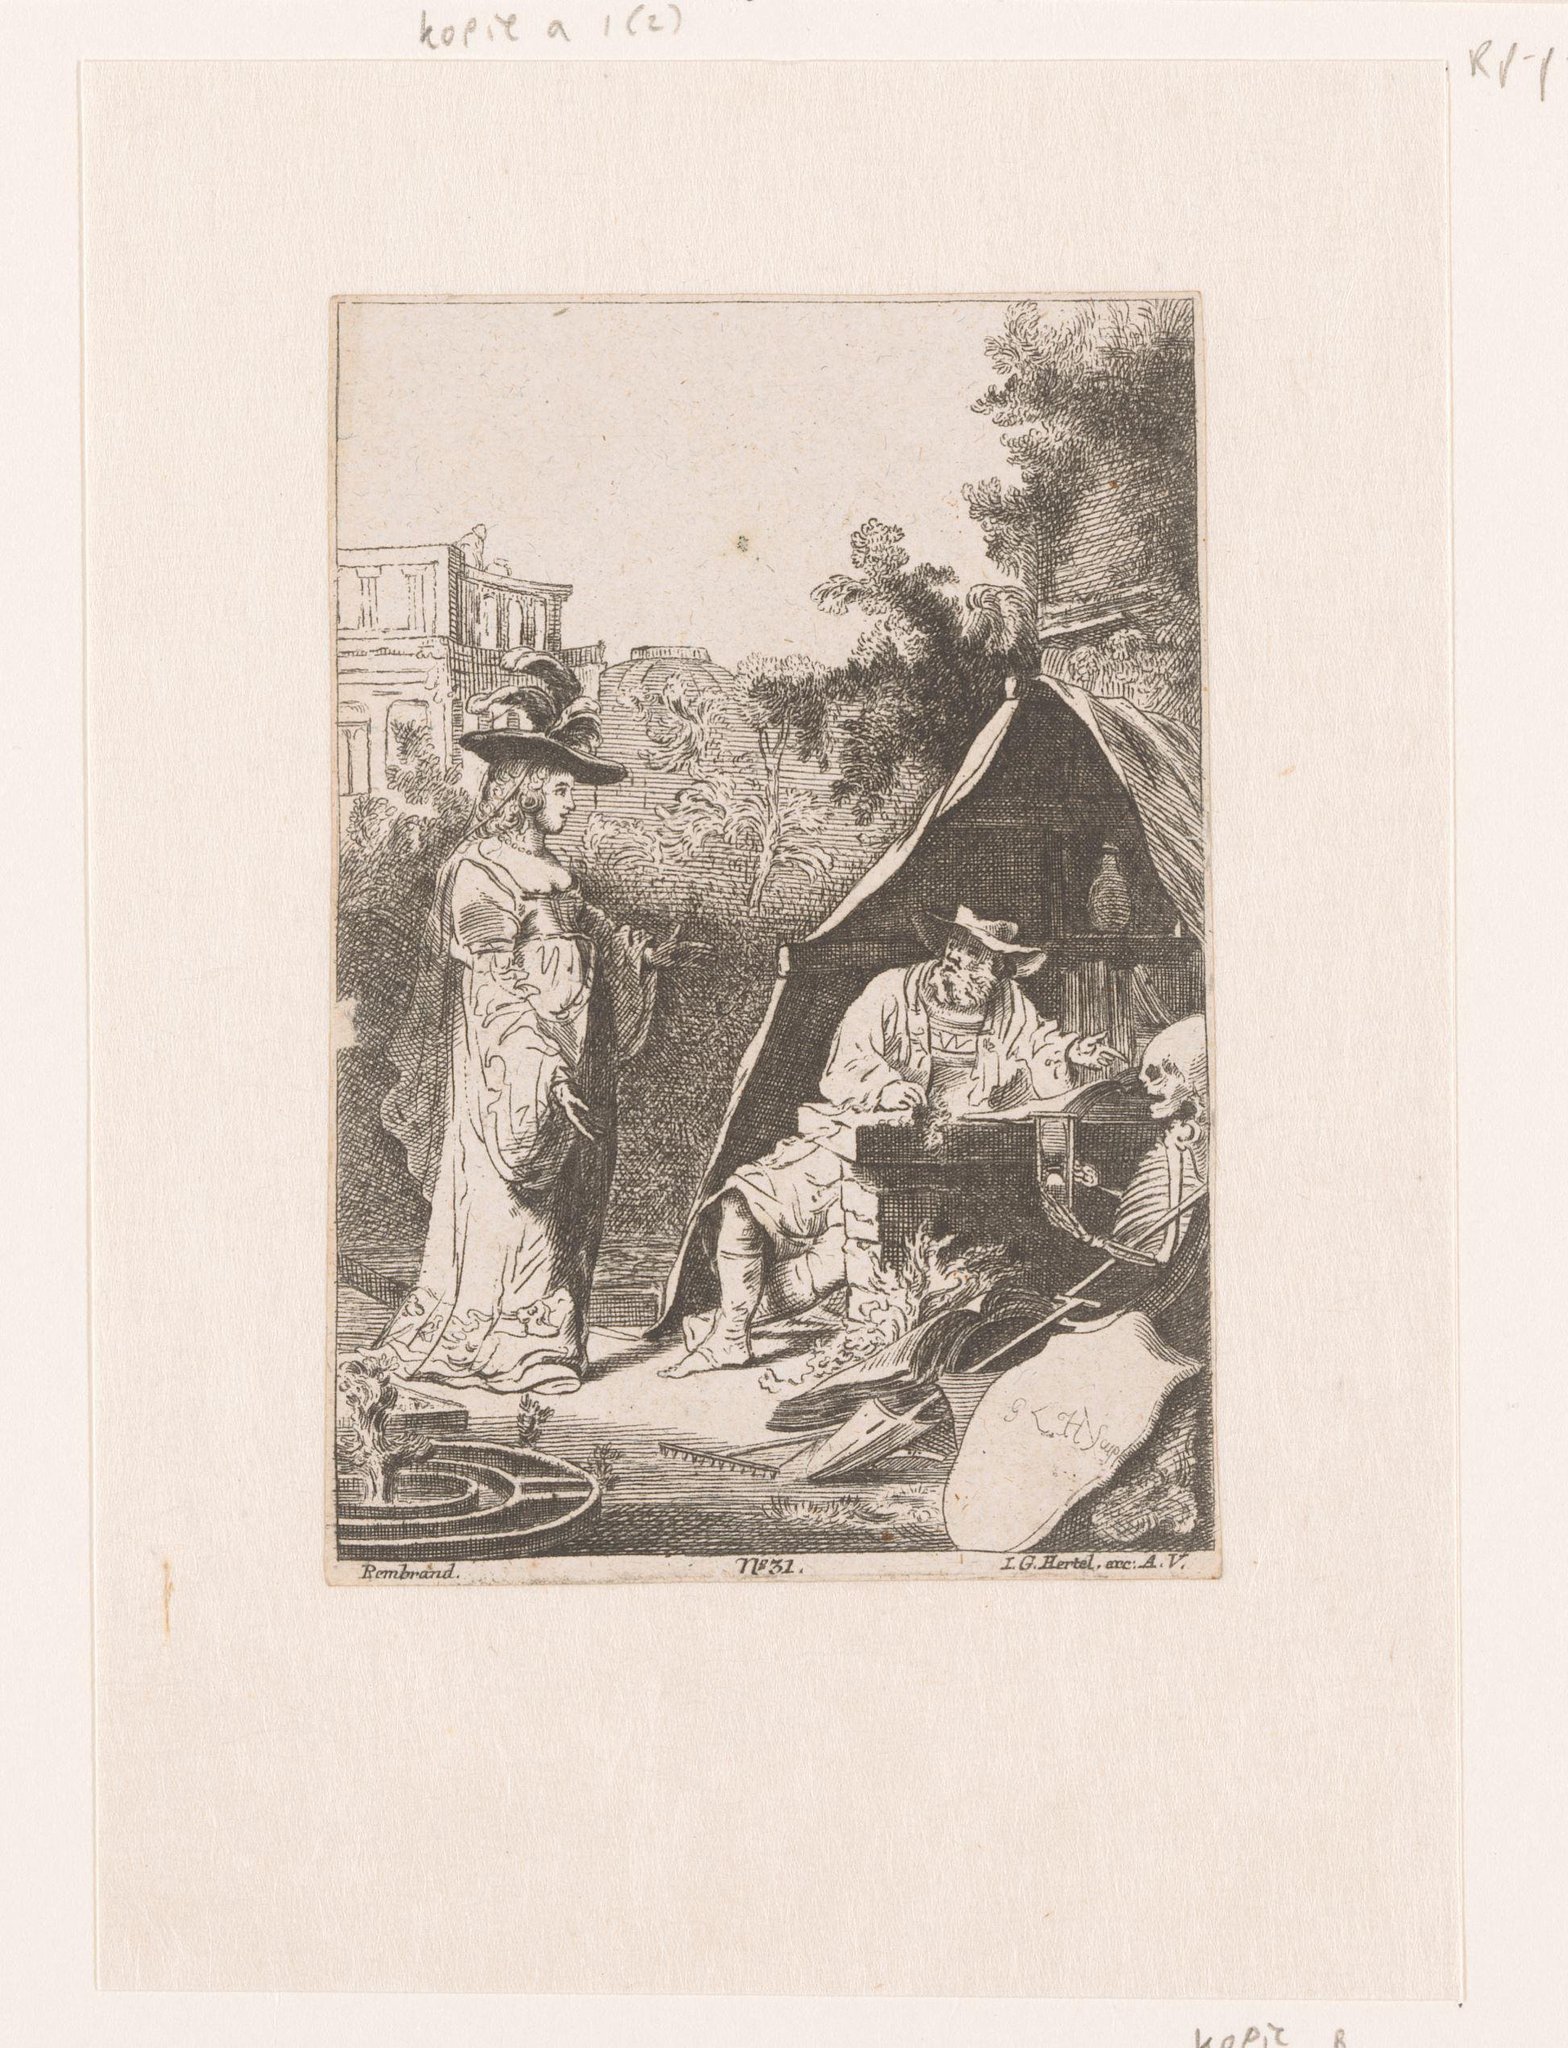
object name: print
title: Jonge vrouw en oude man met De Dood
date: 1750-1778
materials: paper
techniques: etching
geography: augsburg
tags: dance of death; death together with one or more human beings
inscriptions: collector's mark: Lugt 240